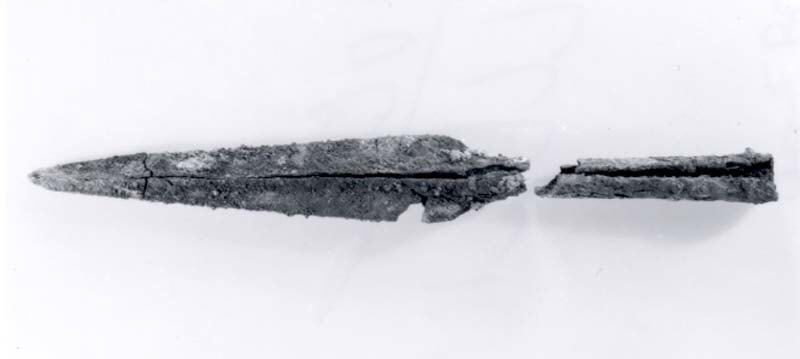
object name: spearhead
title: Spearhead with shaft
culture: iranian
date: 900-801 BCE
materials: iron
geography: iran